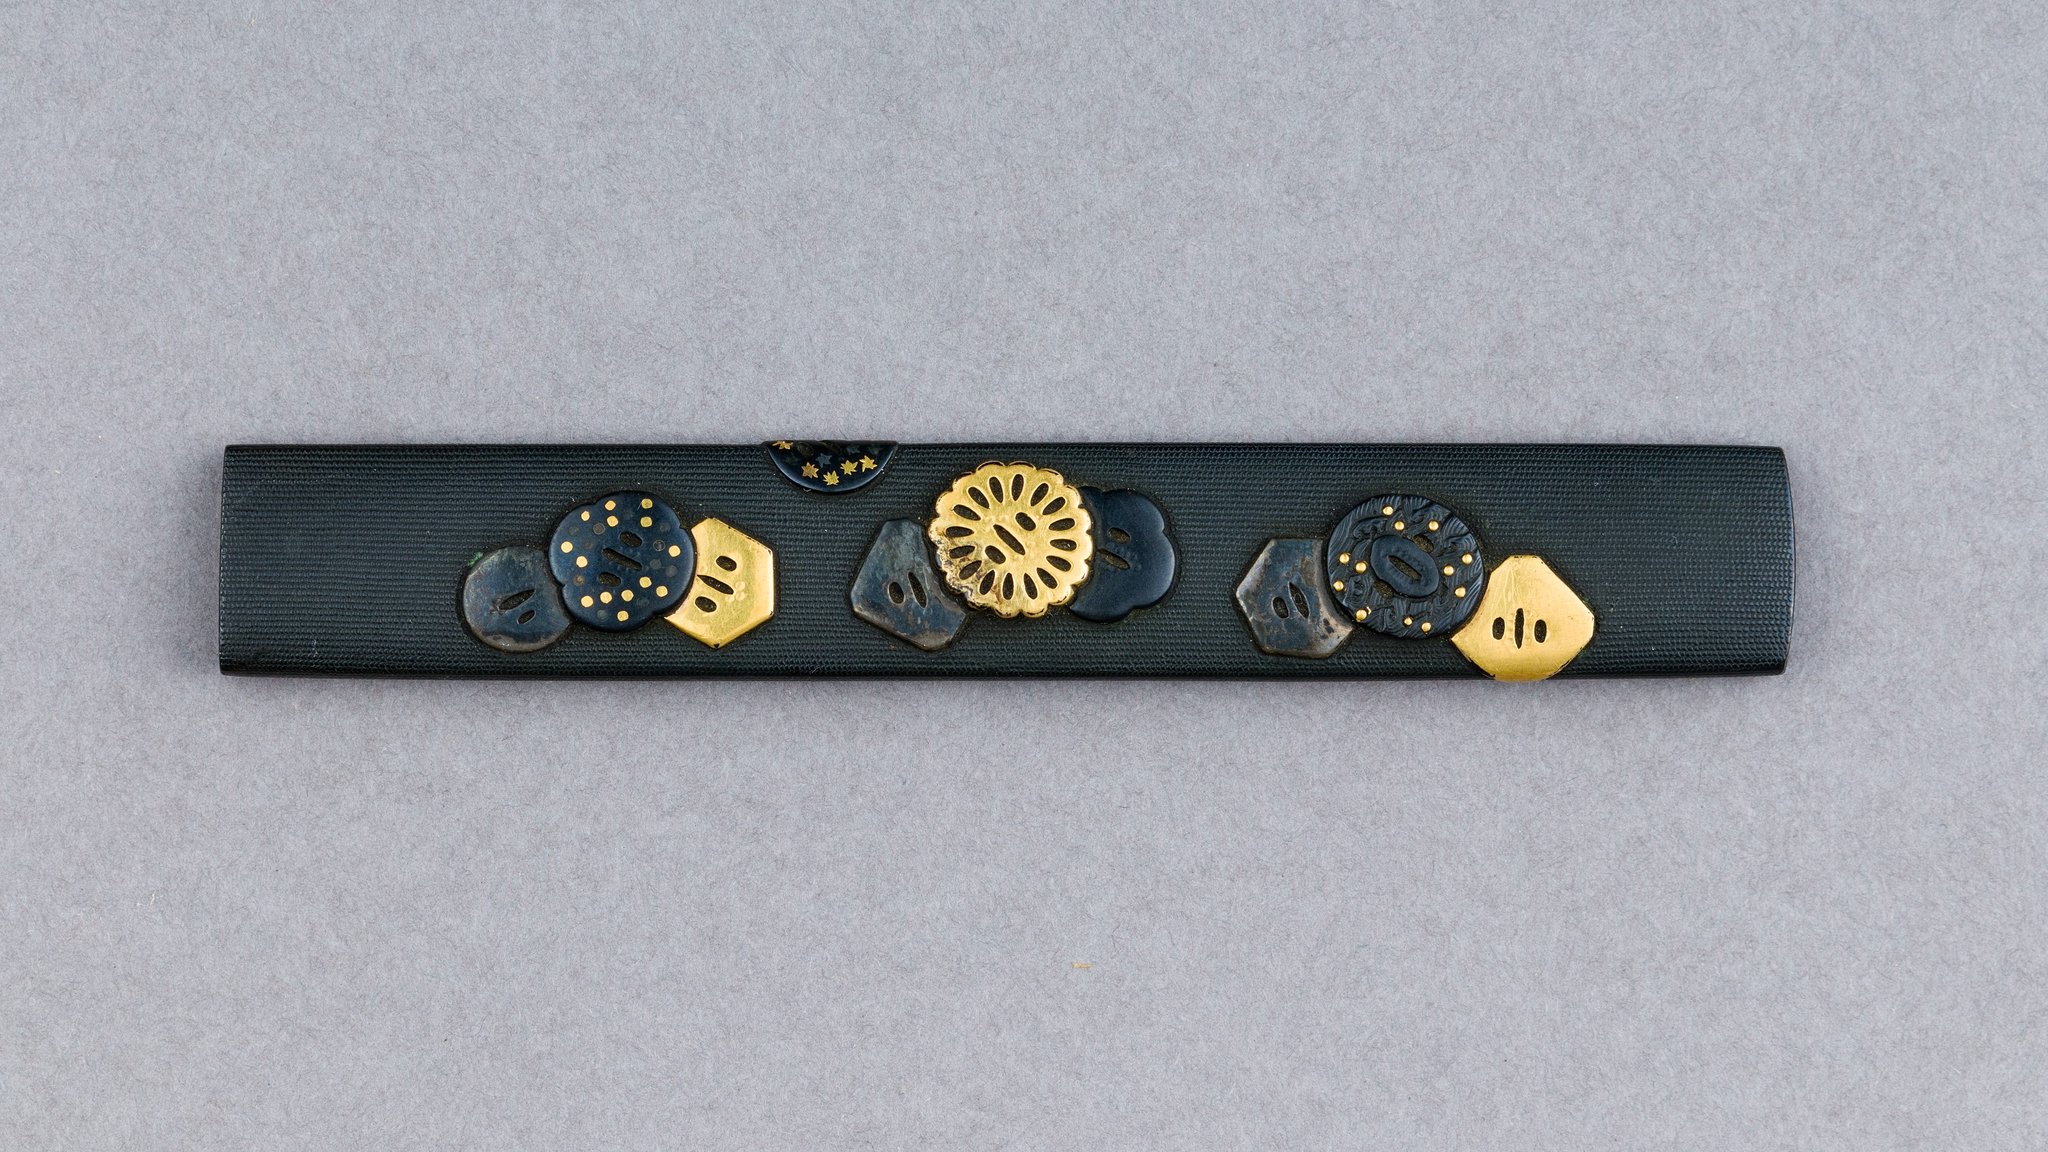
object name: knife handle kozuka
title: Knife Handle (Kozuka)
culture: japanese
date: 1615-1868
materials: gold alloy, gold, silver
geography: japan